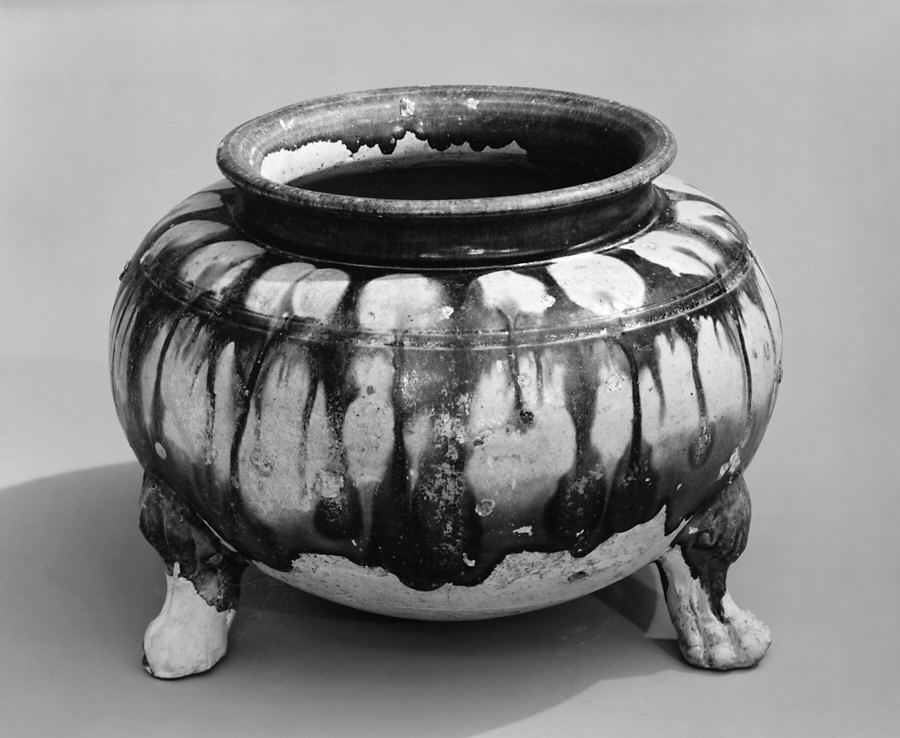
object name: incense burner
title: Tripod incense burner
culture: chinese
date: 701-800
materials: earthenware, glaze